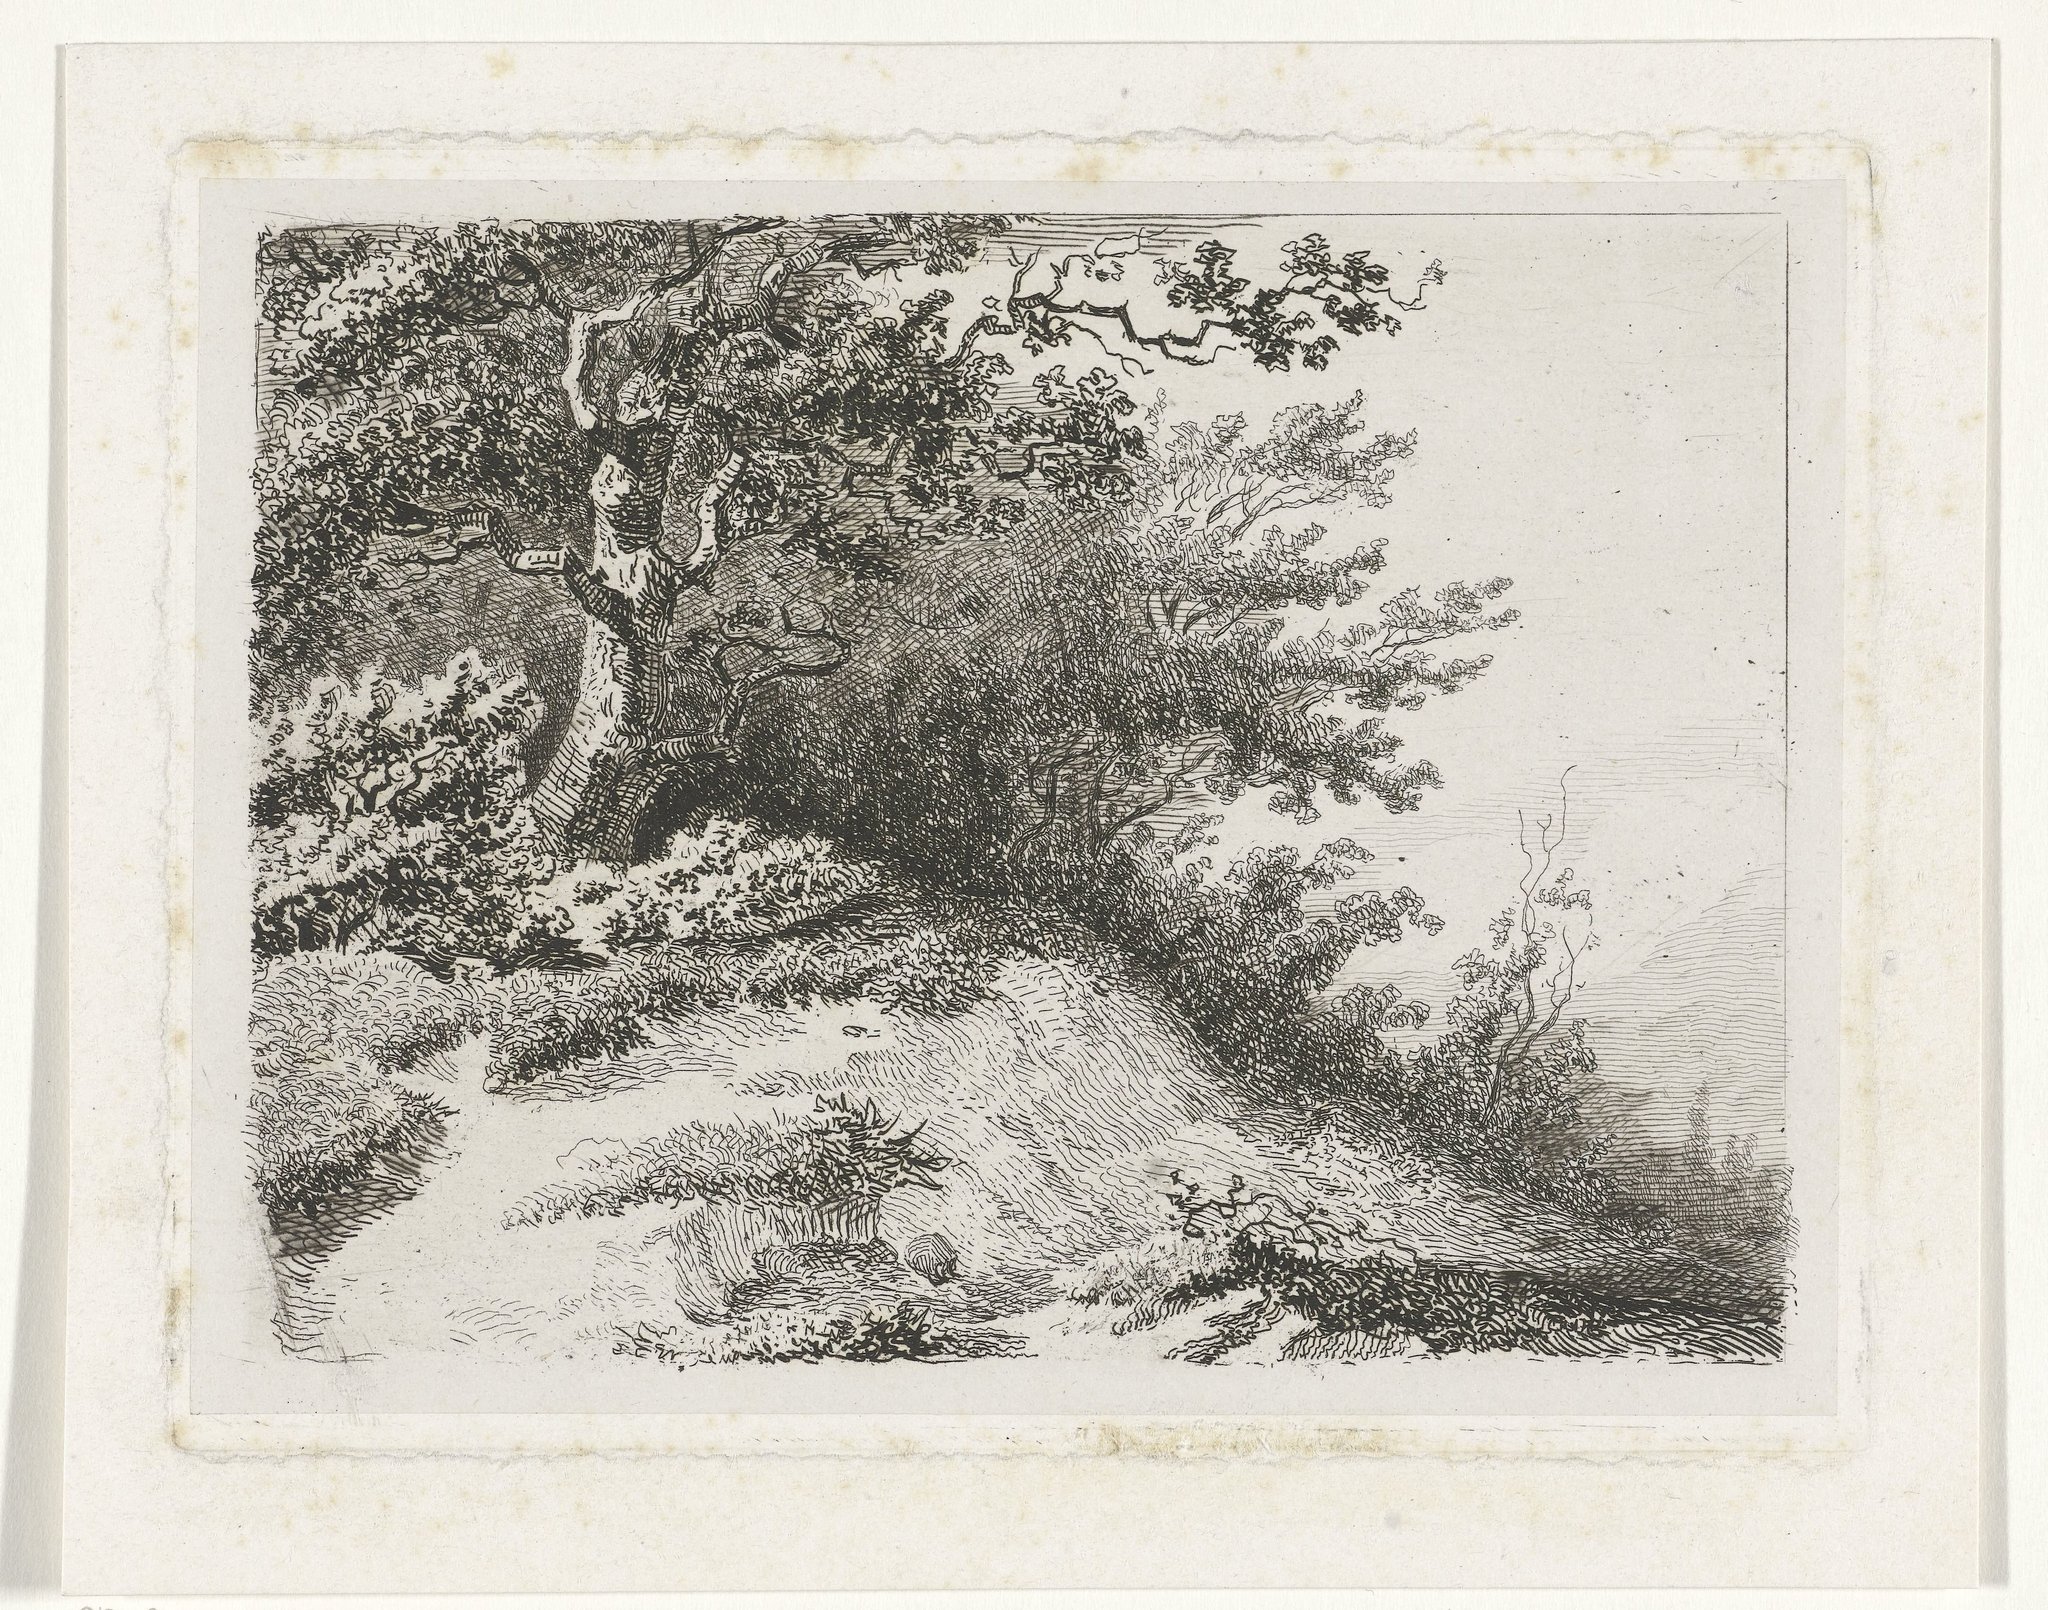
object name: print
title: Boom op een heuvel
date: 1820-1886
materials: paper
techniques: engraving, etching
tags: trees, forest, wood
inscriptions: collector's mark: Lugt 2228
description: Links een boom op een heuvel, op de achtergrond gebladerte.